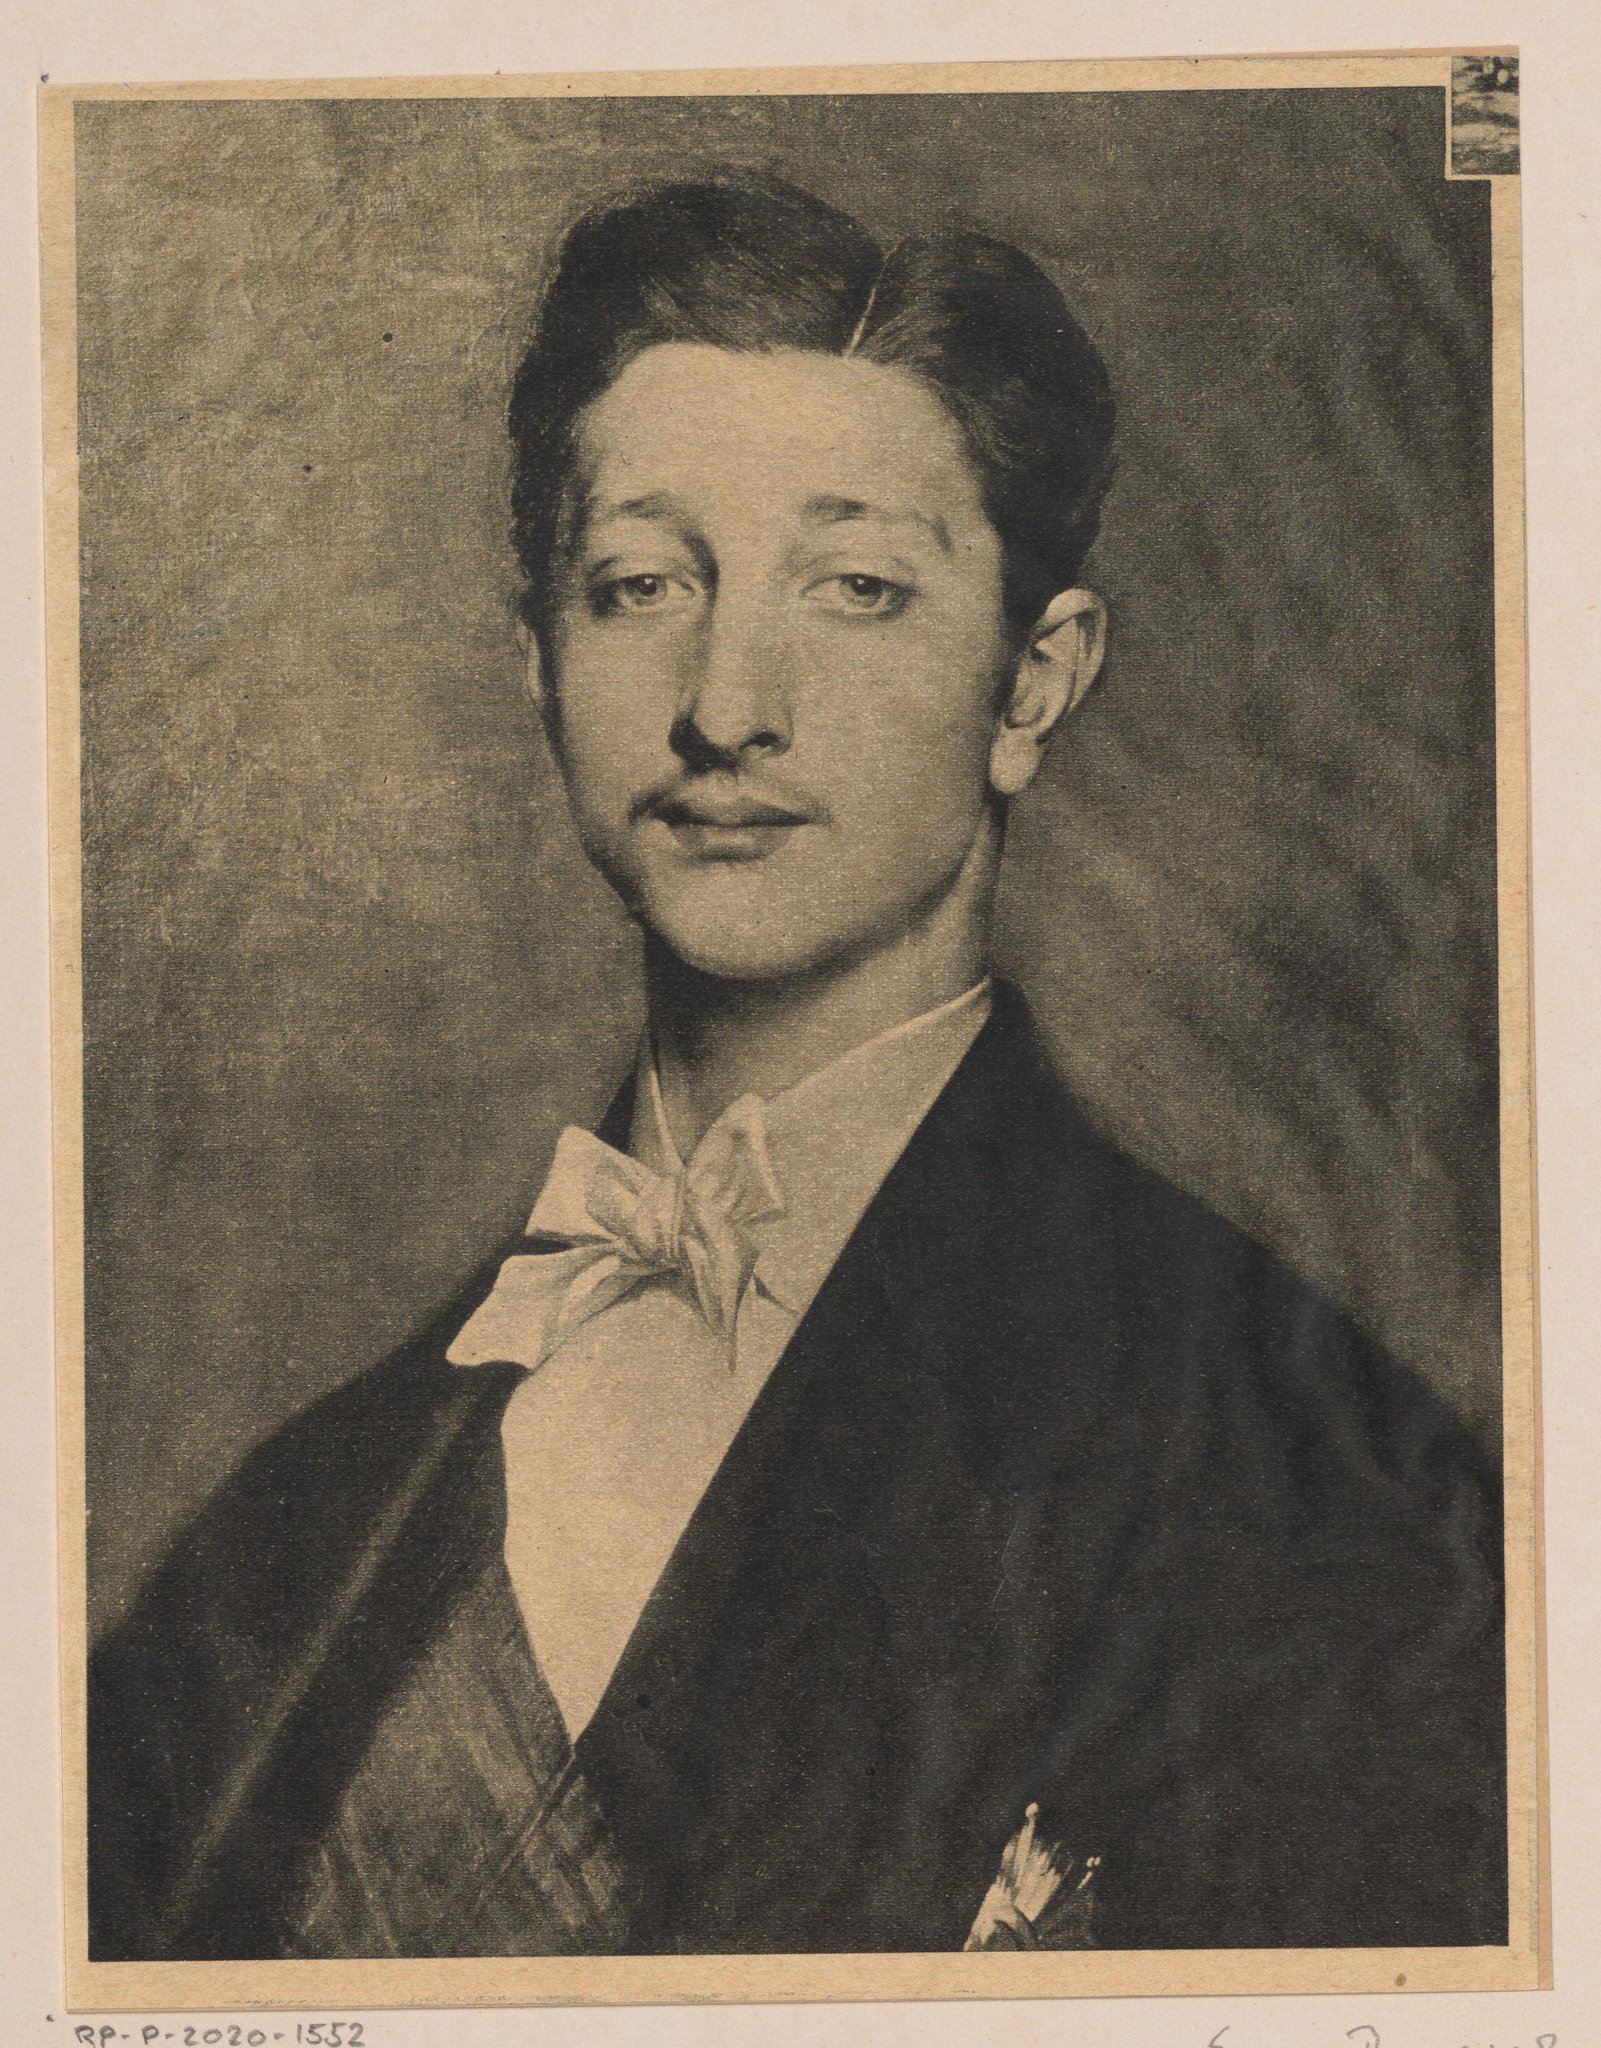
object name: photomechanical print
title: Portret van Napoleon Eugène Lodewijk Bonaparte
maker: Anonymous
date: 1875-1899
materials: paper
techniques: photograph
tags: prince, historical persons